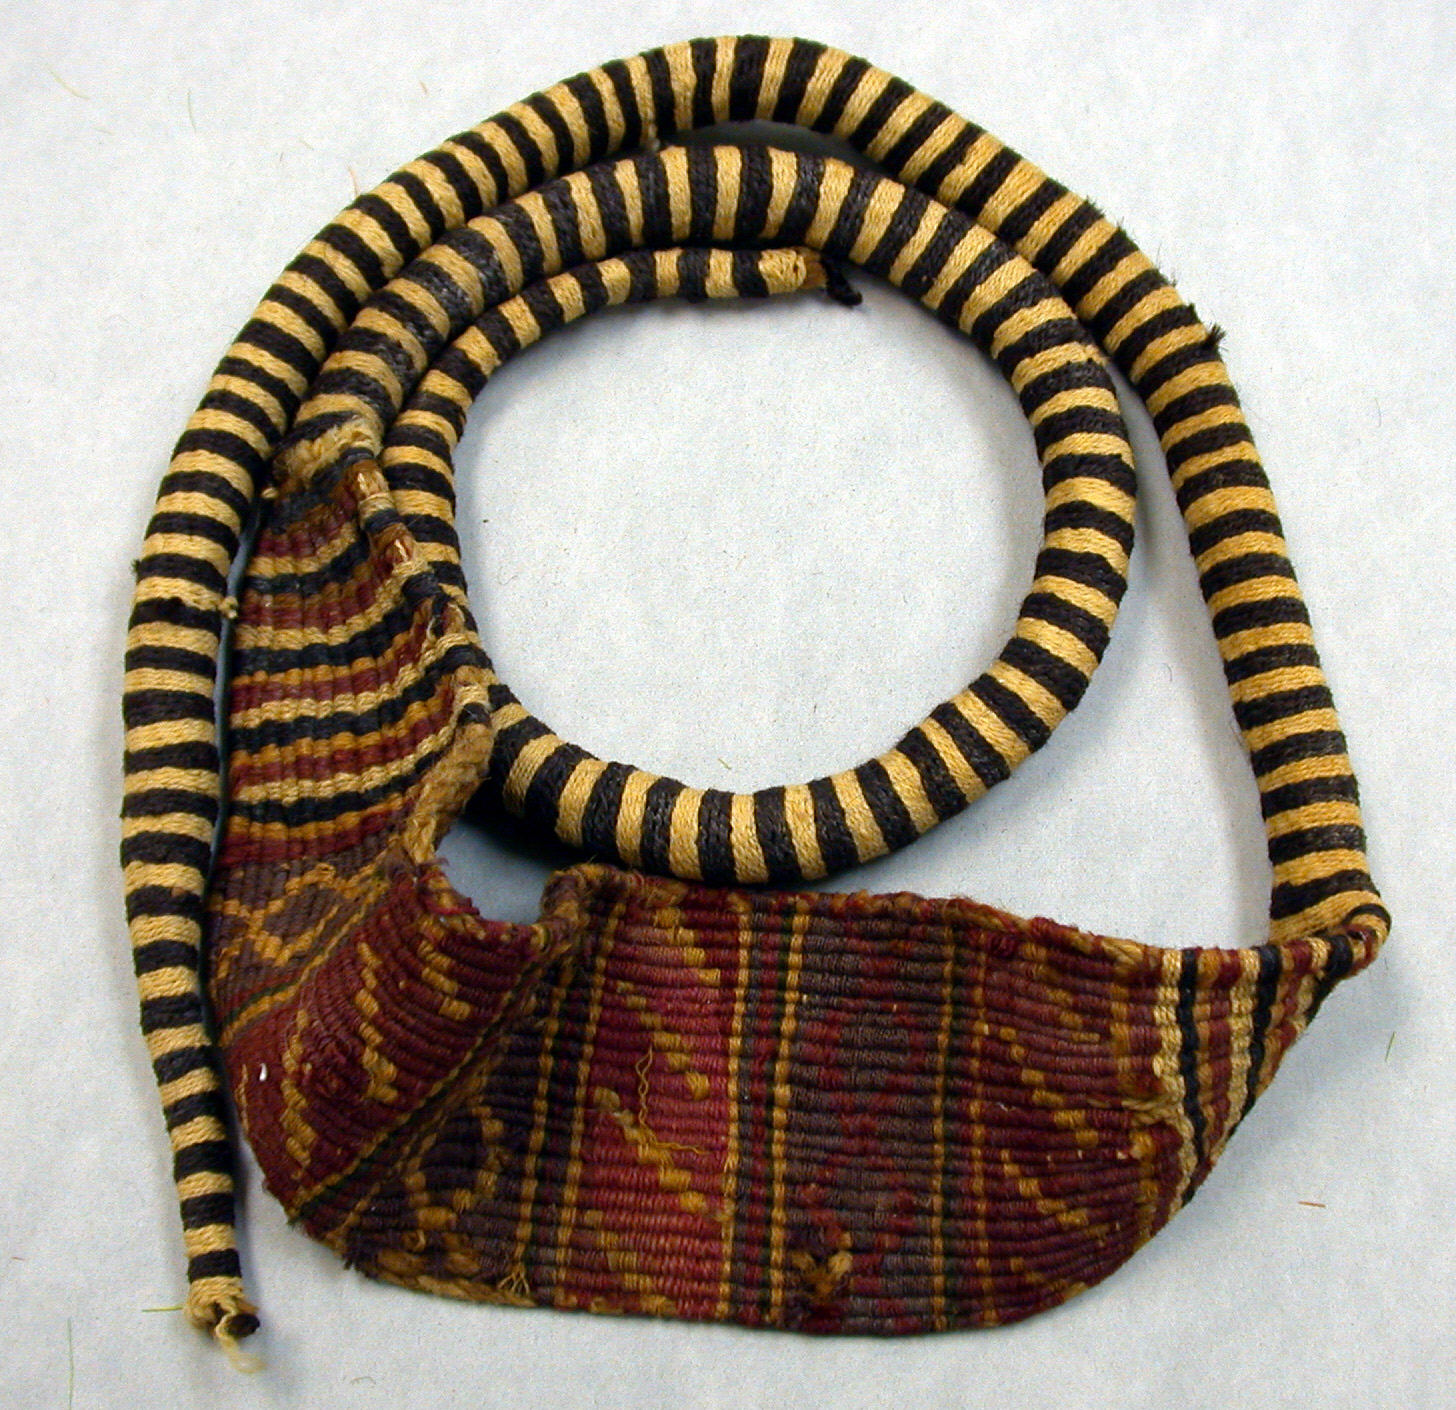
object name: sling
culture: inca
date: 1450-1532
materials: animal fiber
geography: peru